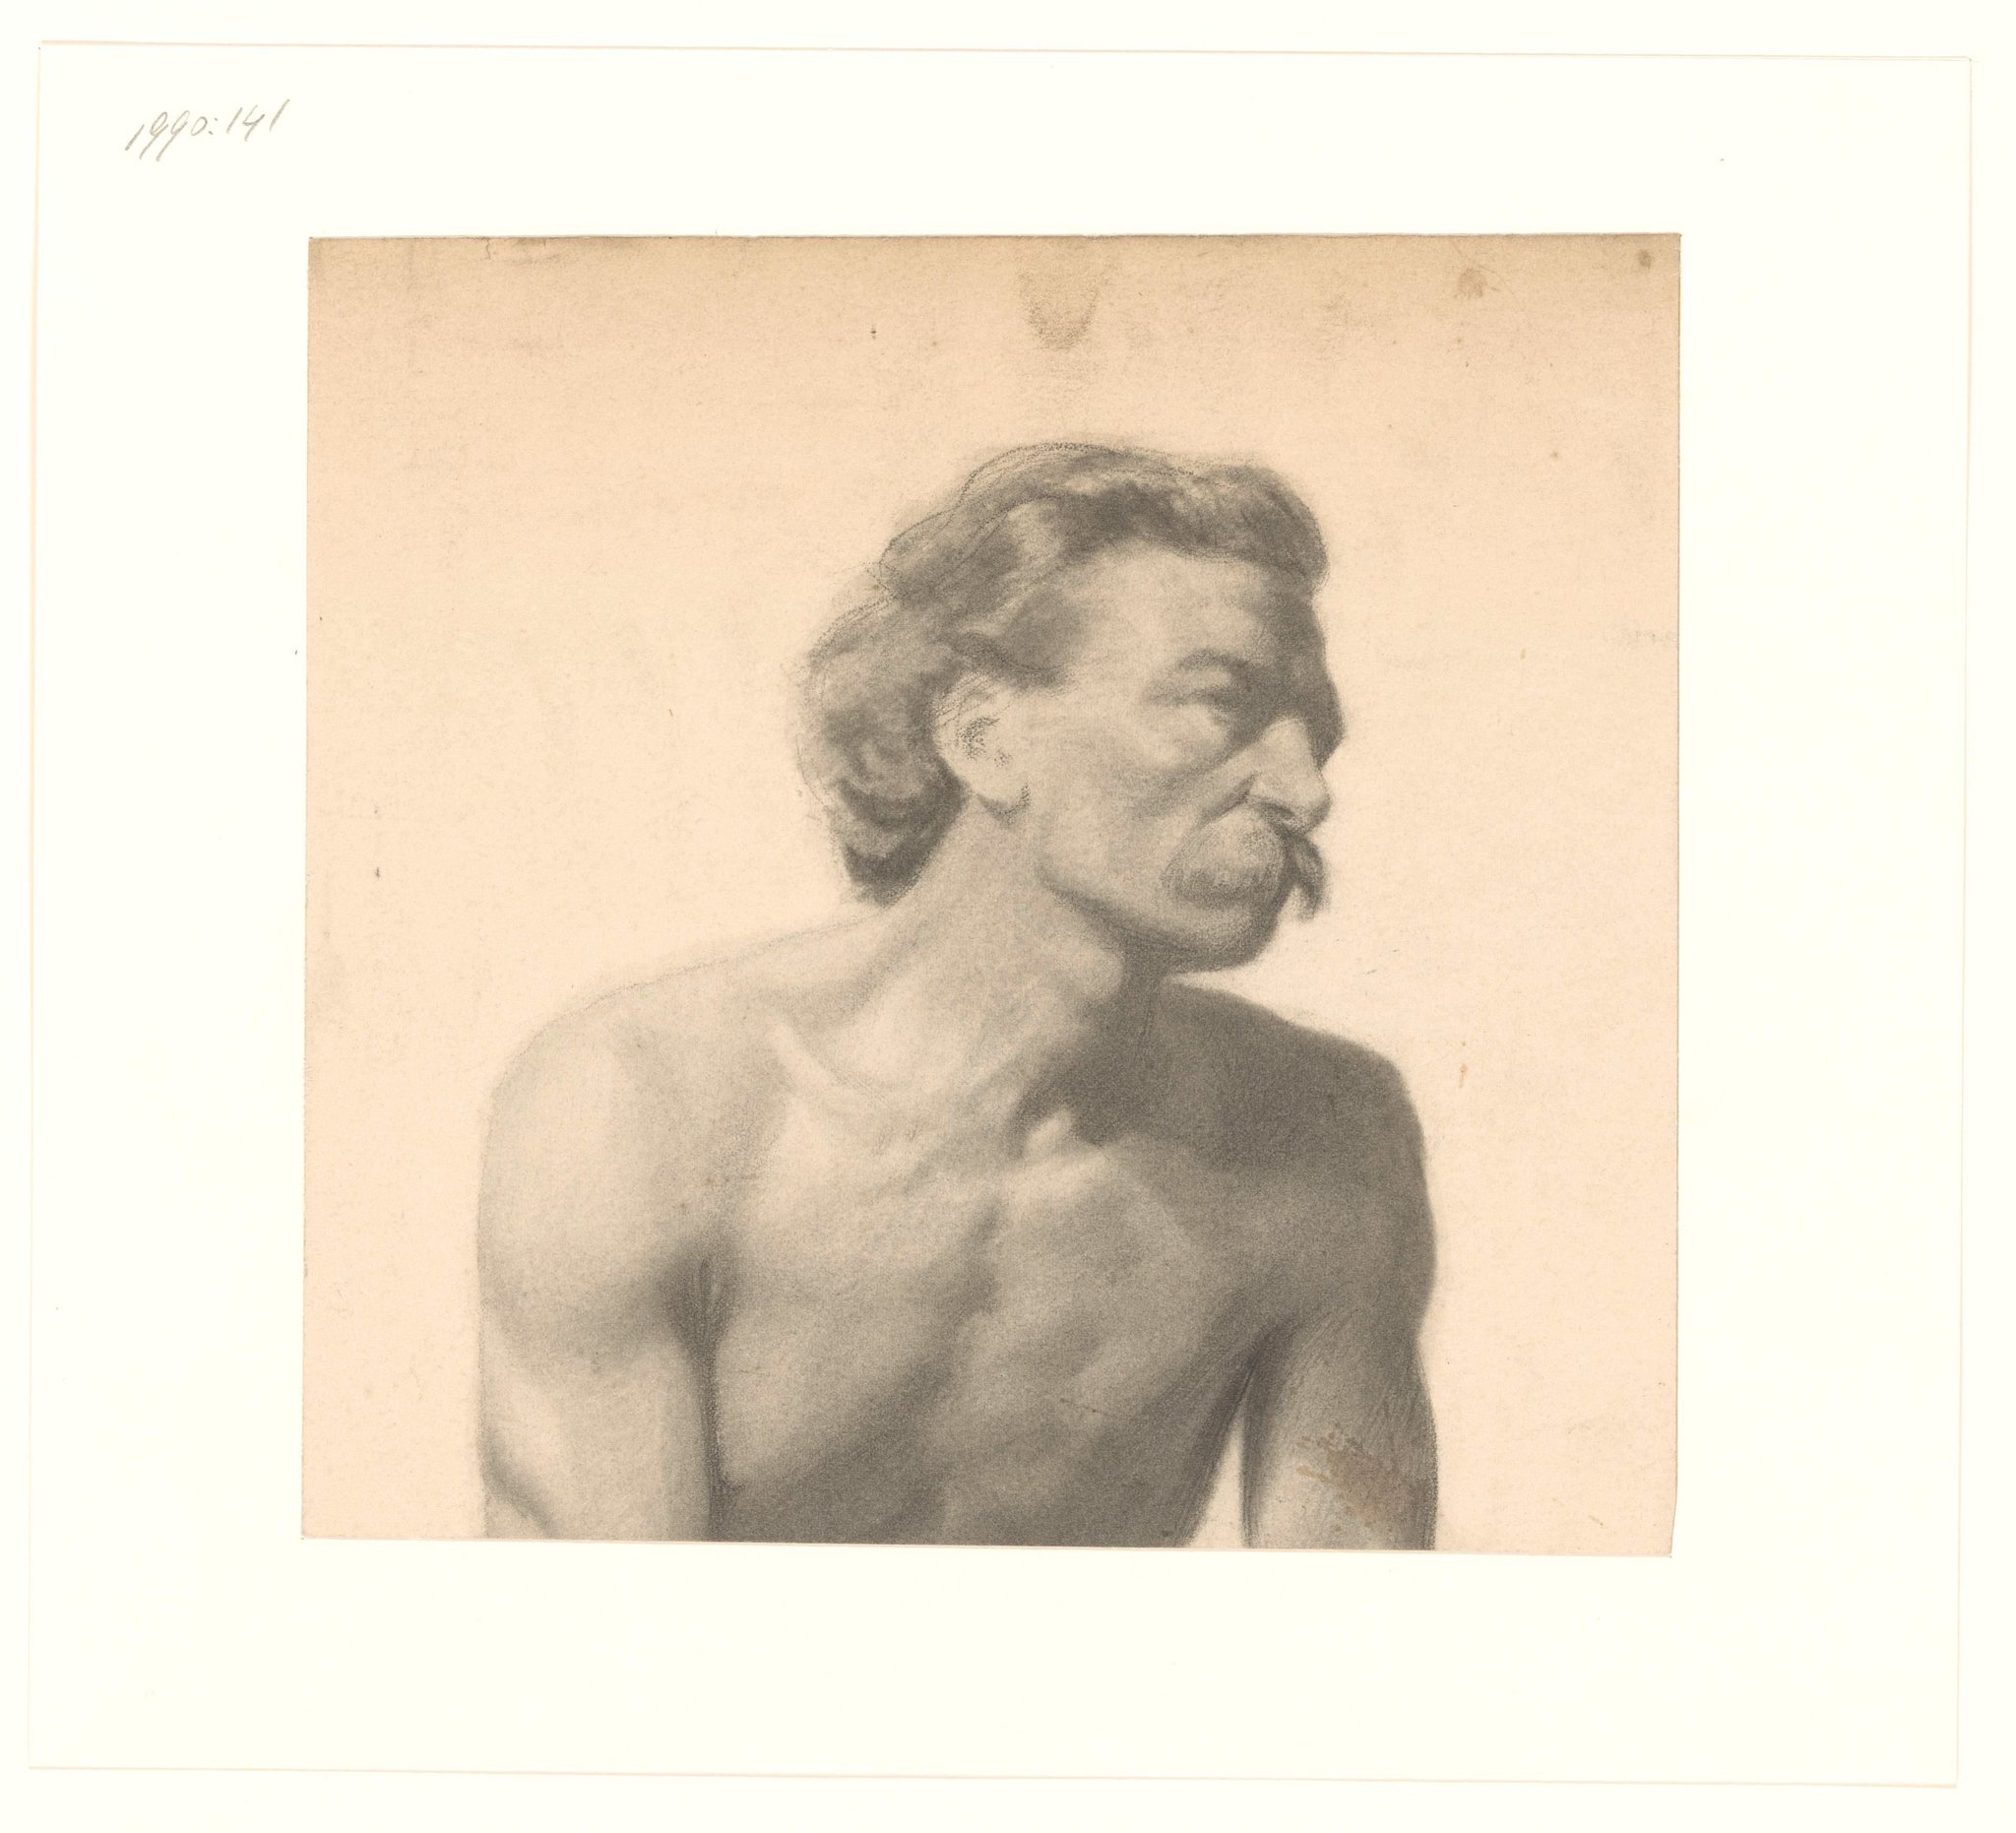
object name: drawing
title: Buste van mannelijk naakt met snor, driekwart naar rechts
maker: johan braakensiek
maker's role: draughtsman, print maker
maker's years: 1858-1940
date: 1868-1940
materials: chalk, paper